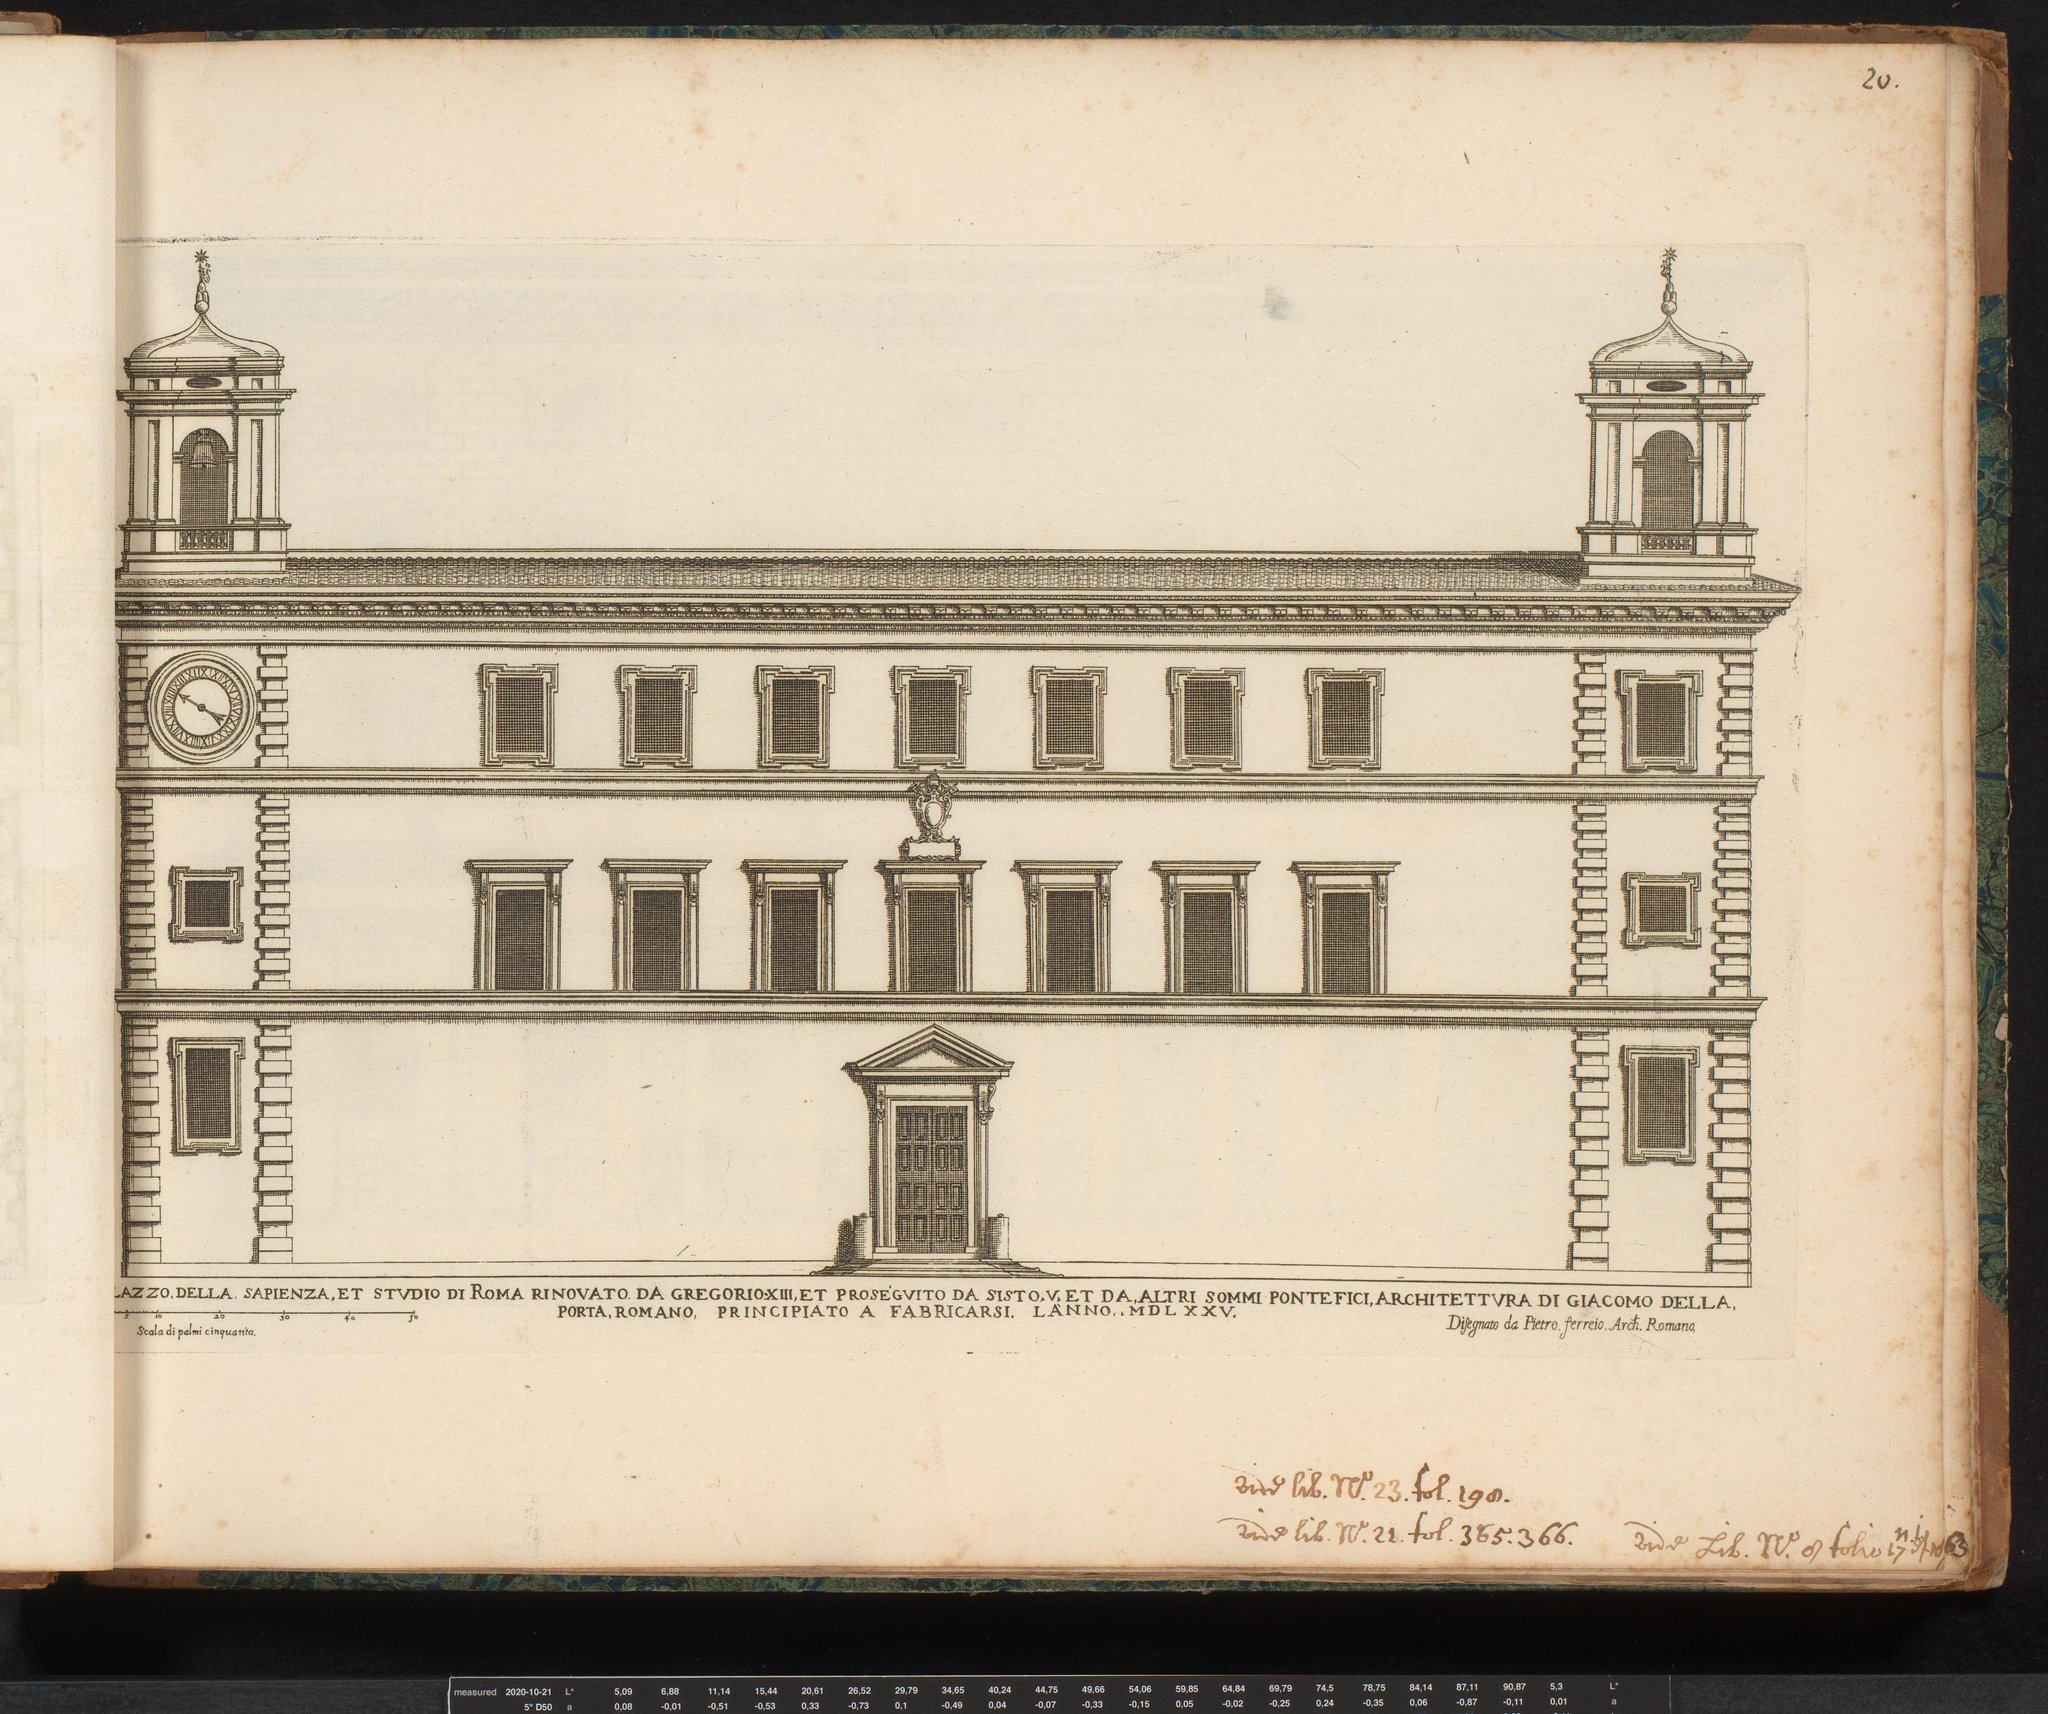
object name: album leaf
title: Palazzo della sapienza et studio di Roma rinovato da Gregorio XII (...)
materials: paper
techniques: etching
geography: rome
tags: gregorius xiii, palace, façade (of house or building)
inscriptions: number: ‘20’, inscription: ‘Ende lib. No. 23. fol. 198/ Ende lib. No. 21. fol. 365. 366./ Ende lib. No. 8 folio...’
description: Deze prent maakt deel uit van de reeks getiteld: Palazzi di Roma. Deze reeks bestaat uit twee boeken. Boek één getiteld: Palazzi di Roma dei più celebri architetti..., bestaat uit 44 prenten die worden toegeschreven aan Giovanni Battista Falda (naam staat enkel op prent 27) en uitgegeven door Giovanni Giacomo de'Rossi. Deze 44 prenten zijn bekend in twee staten (met en zonder nummer). Boek twee getiteld: Nuovi disegni dell'architetture... libro secondo, bevat 66 prenten door Giovanni Battista Falda en Simone Felice. Deze 66 prenten zijn bekend in twee staten (met en zonder nummer).